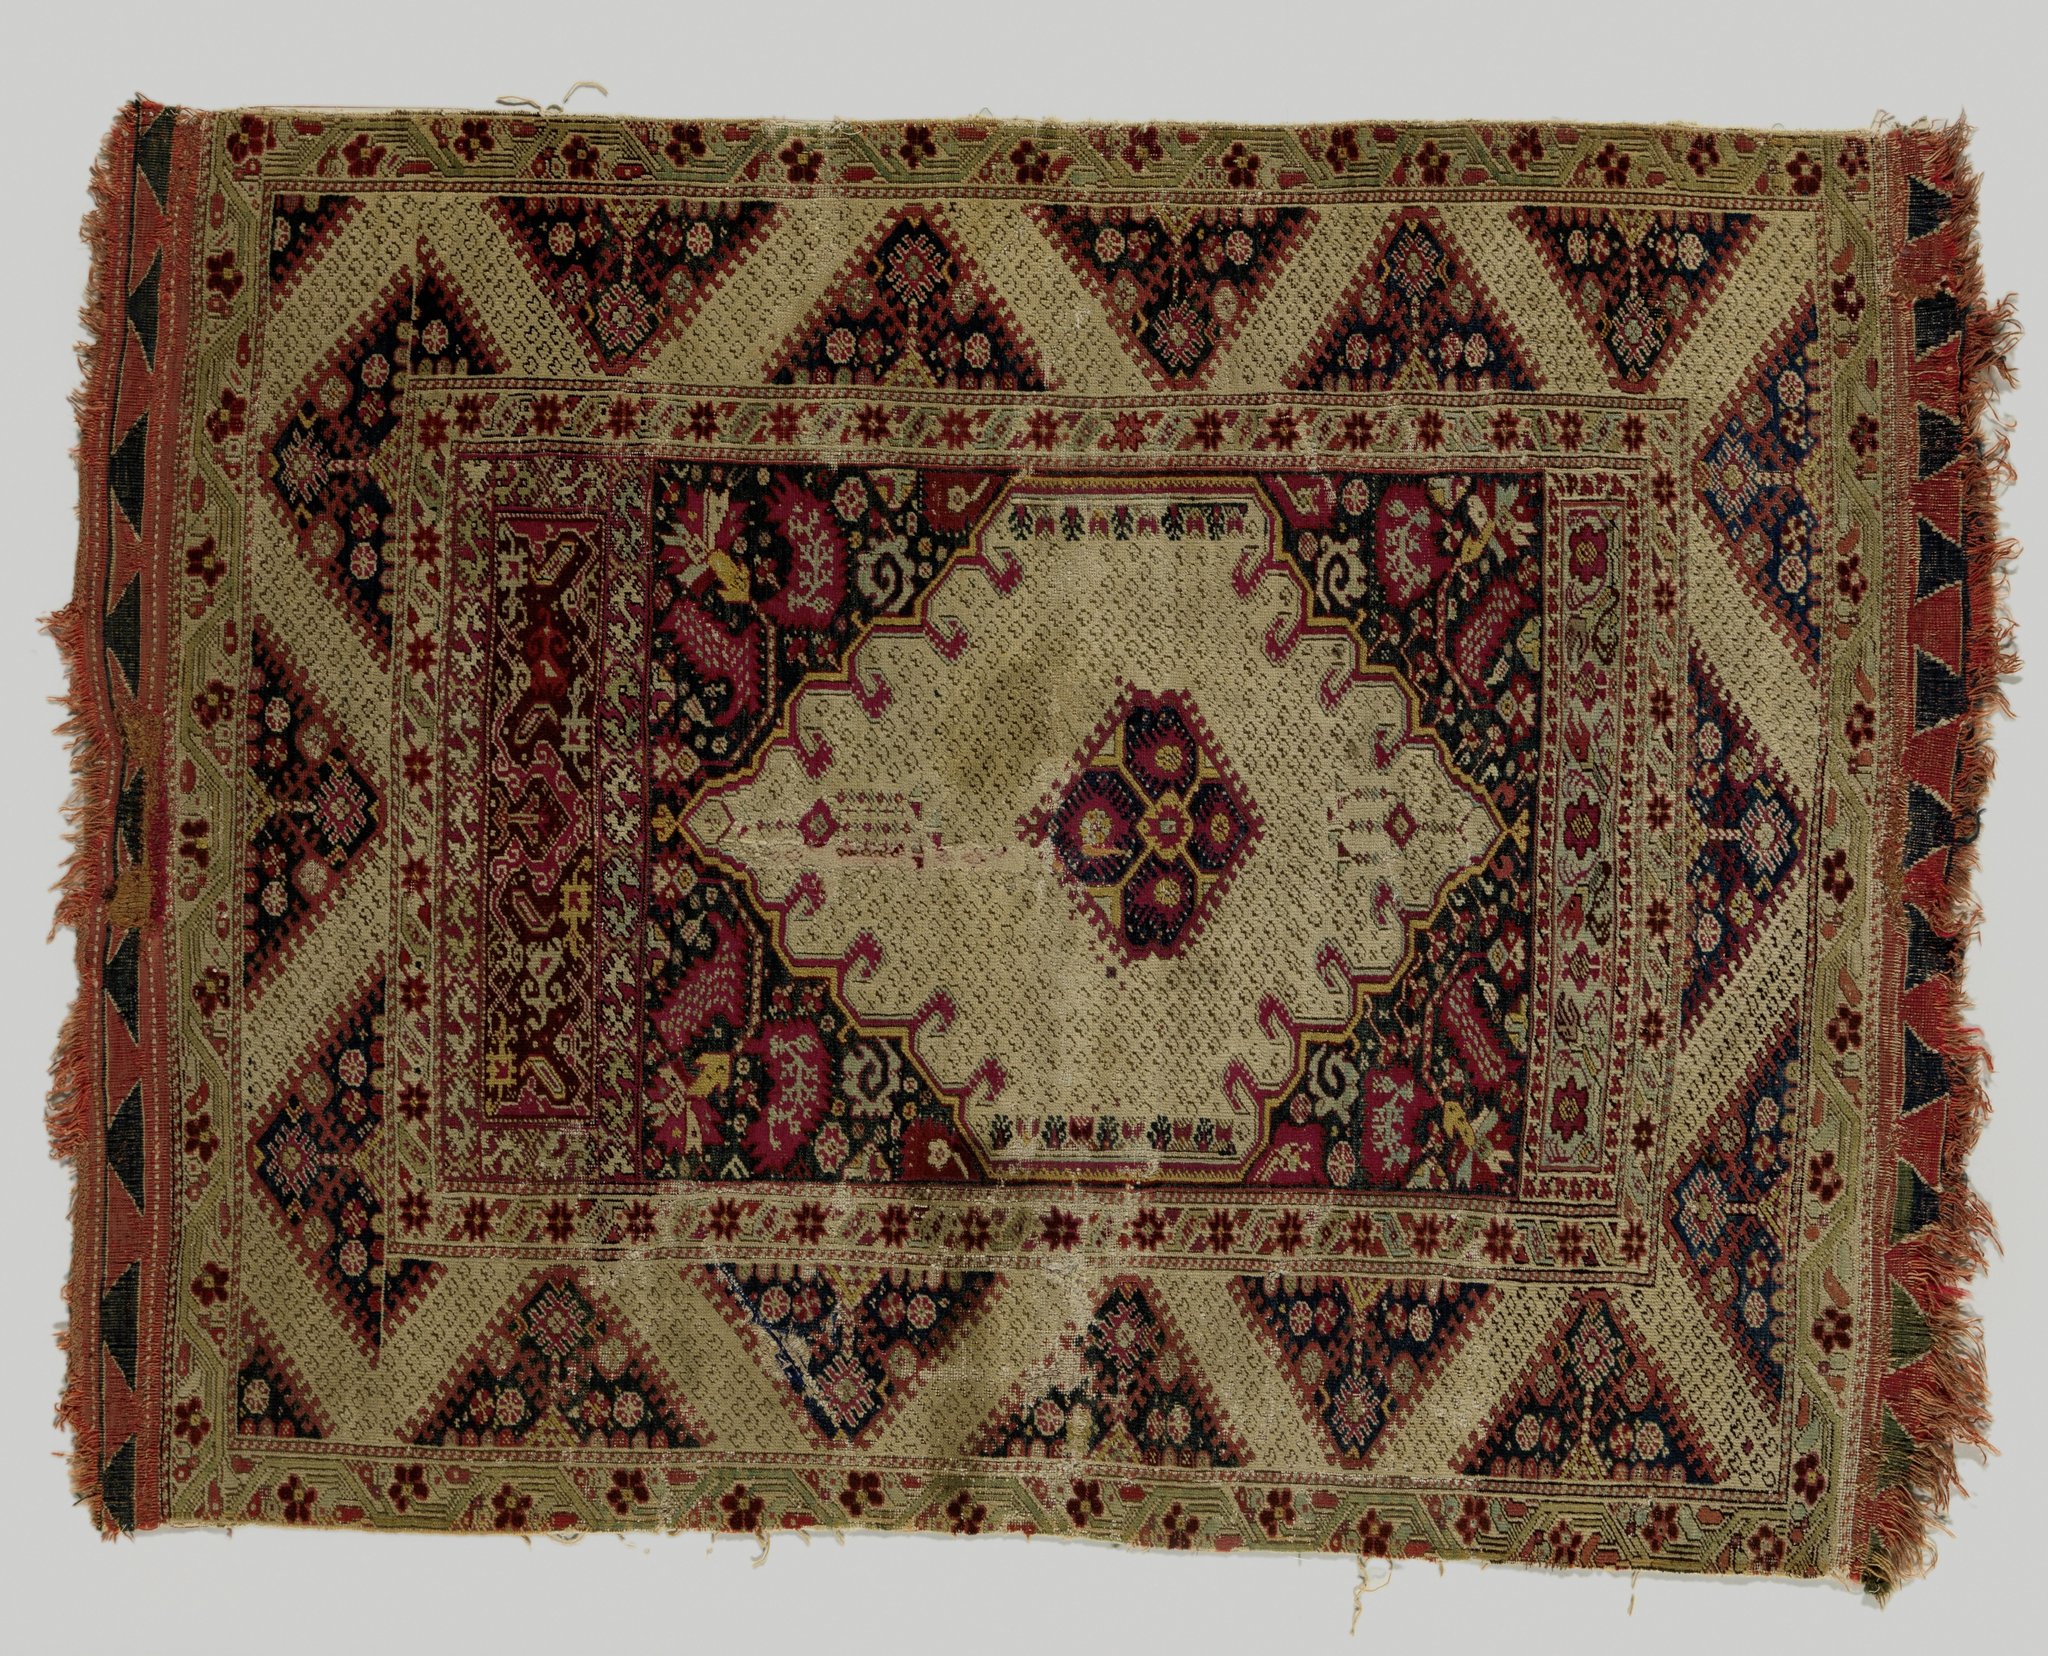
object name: oriental rug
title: Bidkleed voor een meisje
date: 1775-1900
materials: wool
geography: ghiordes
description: Bidkleed voor een meisje, z.g. Kis-Ghiordes van geknoopte wol met op het middenveld een dubbele Mihrab van wit met gestrooide vulling van kleine halve manen. Rand met witte zigzag-banden.